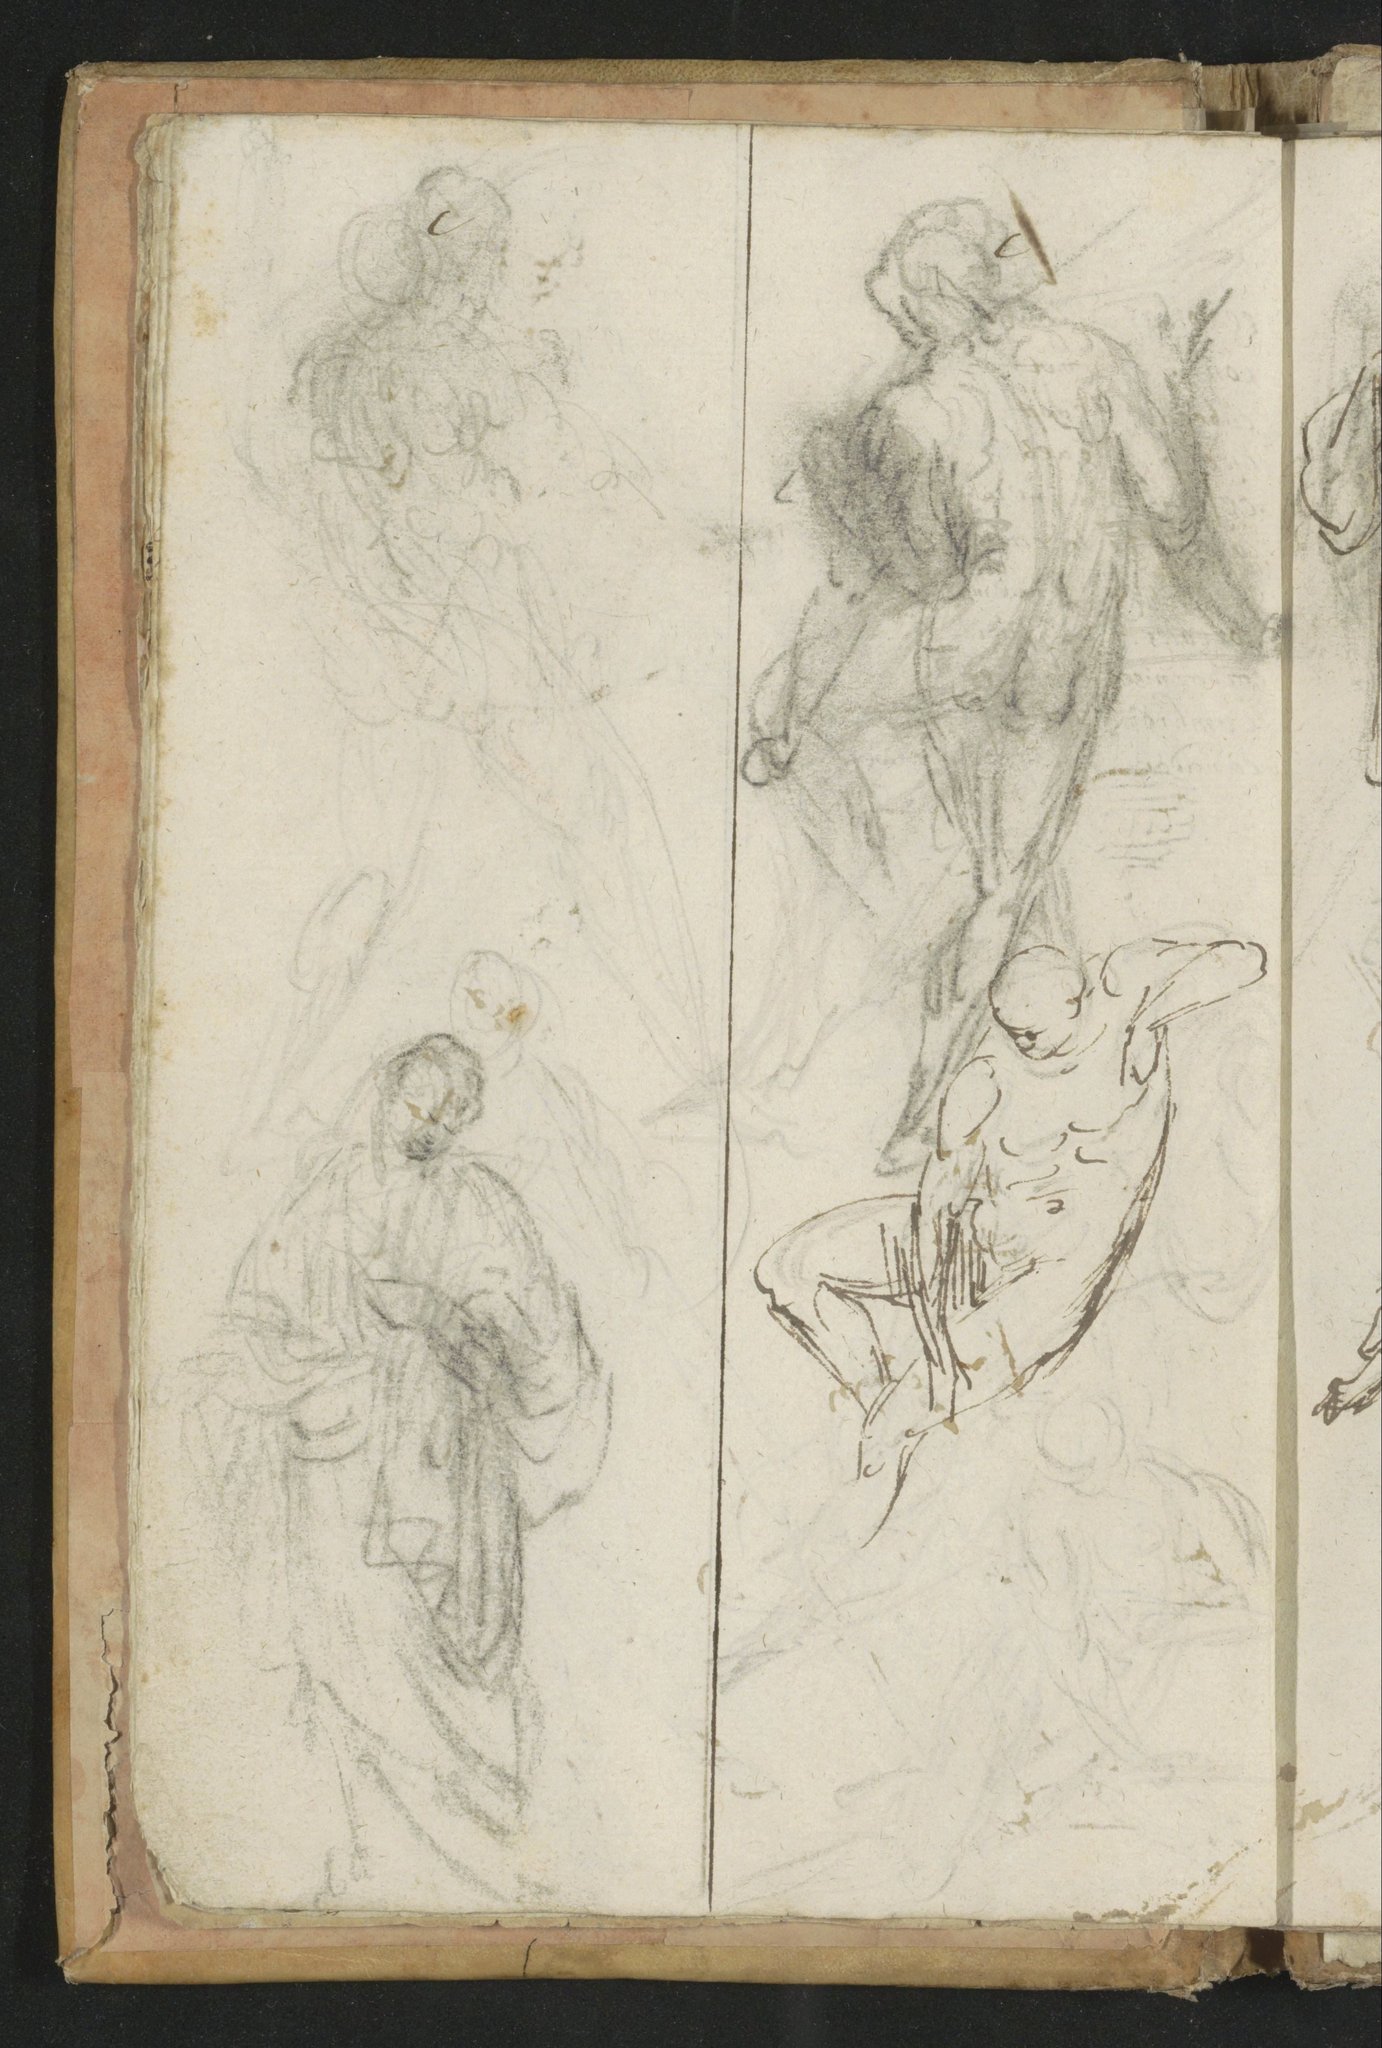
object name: sketchbook leaf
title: Staande en zittende figuren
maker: Anonymous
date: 1658-1728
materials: chalk, ink, paper, pencil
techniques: pen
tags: standing figure, sitting figure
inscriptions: annotation: ‘c c’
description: Blad 5 verso uit een schetsboek met 33 bladen.